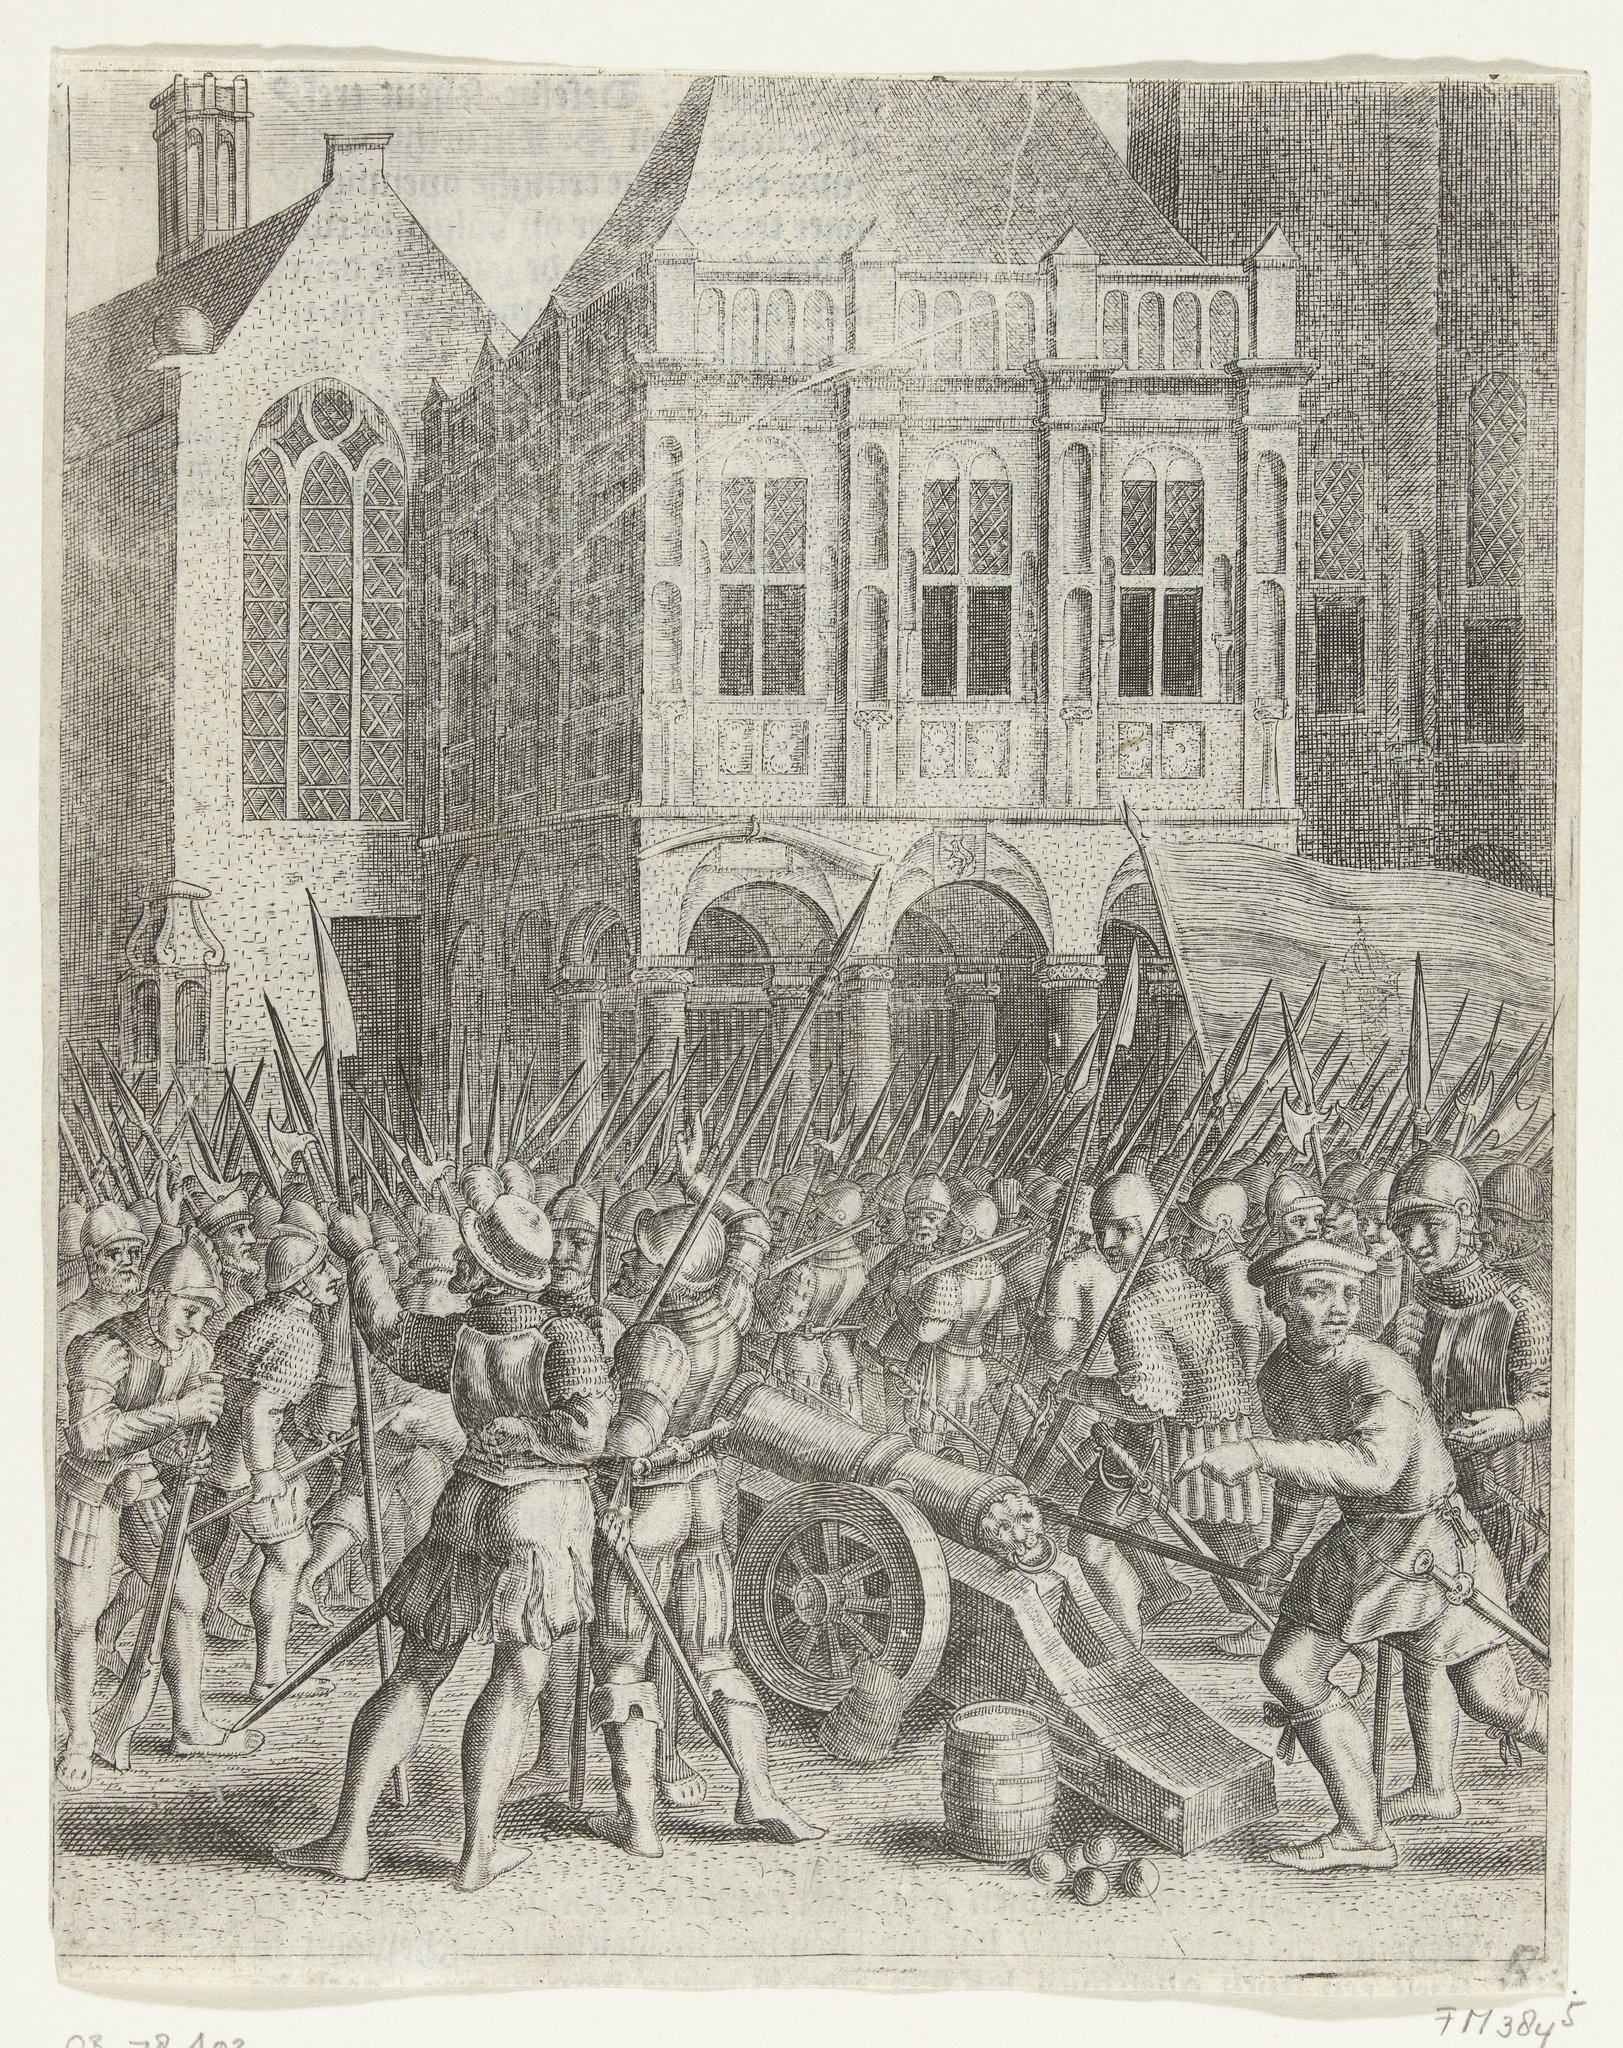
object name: print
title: Aanval op de wederdopers in het stadhuis, 1535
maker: Anonymous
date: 1612-1614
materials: paper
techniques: engraving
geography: northern netherlands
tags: dam, stadhuis van amsterdam (14e eeuw-1652), wederdopersoproer in amsterdam en friesland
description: Illustratie voor: L. Hortensius, Het boeck D. Lamberti Hortensii (...). Van den oproer der weder-dooperen, J. L. Meyn, Enkhuizen 1614, p. 22. Naar het verloren gegane schilderij van Barend Dircksz. in het oude stadhuis te Amsterdam.